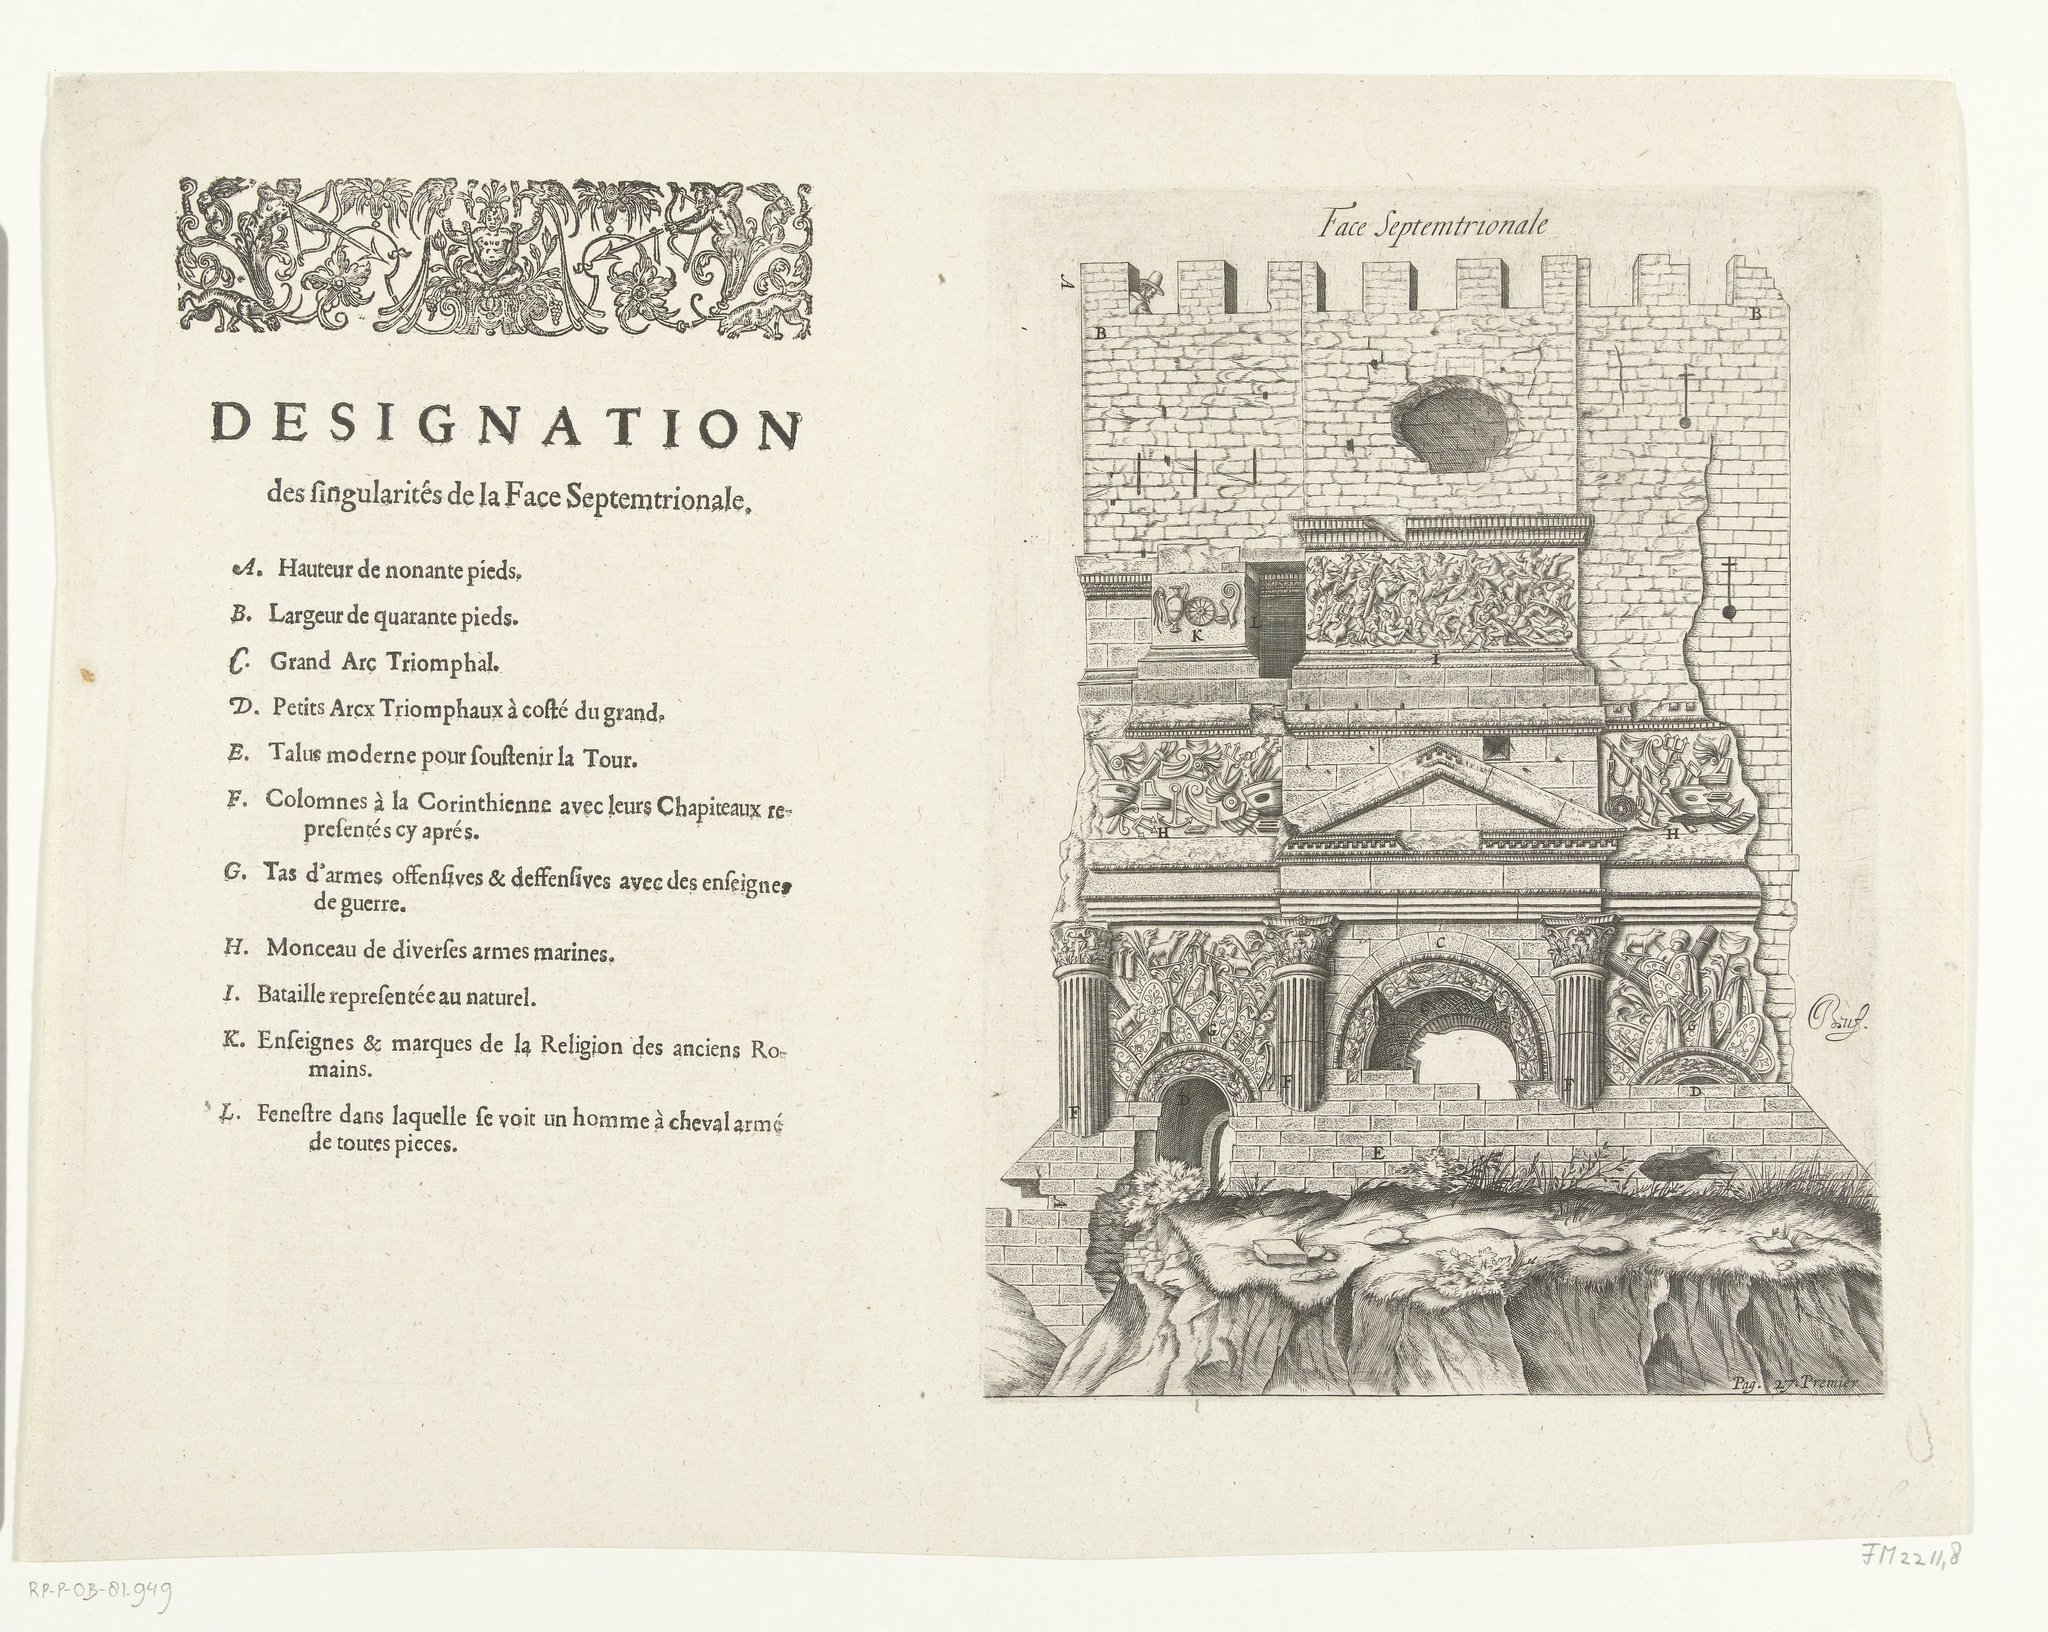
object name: print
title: Romeinse triomfboog in Orange, 1639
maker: jean beuf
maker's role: print maker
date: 1637-1640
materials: paper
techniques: engraving, letterpress printing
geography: france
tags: triumphal arch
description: Gebruikt als illustratie in: Joseph de la Pisé, Tableau de l'histoire des princes et principauté d'Orange, Den Haag, 1639-1640, p. 27.